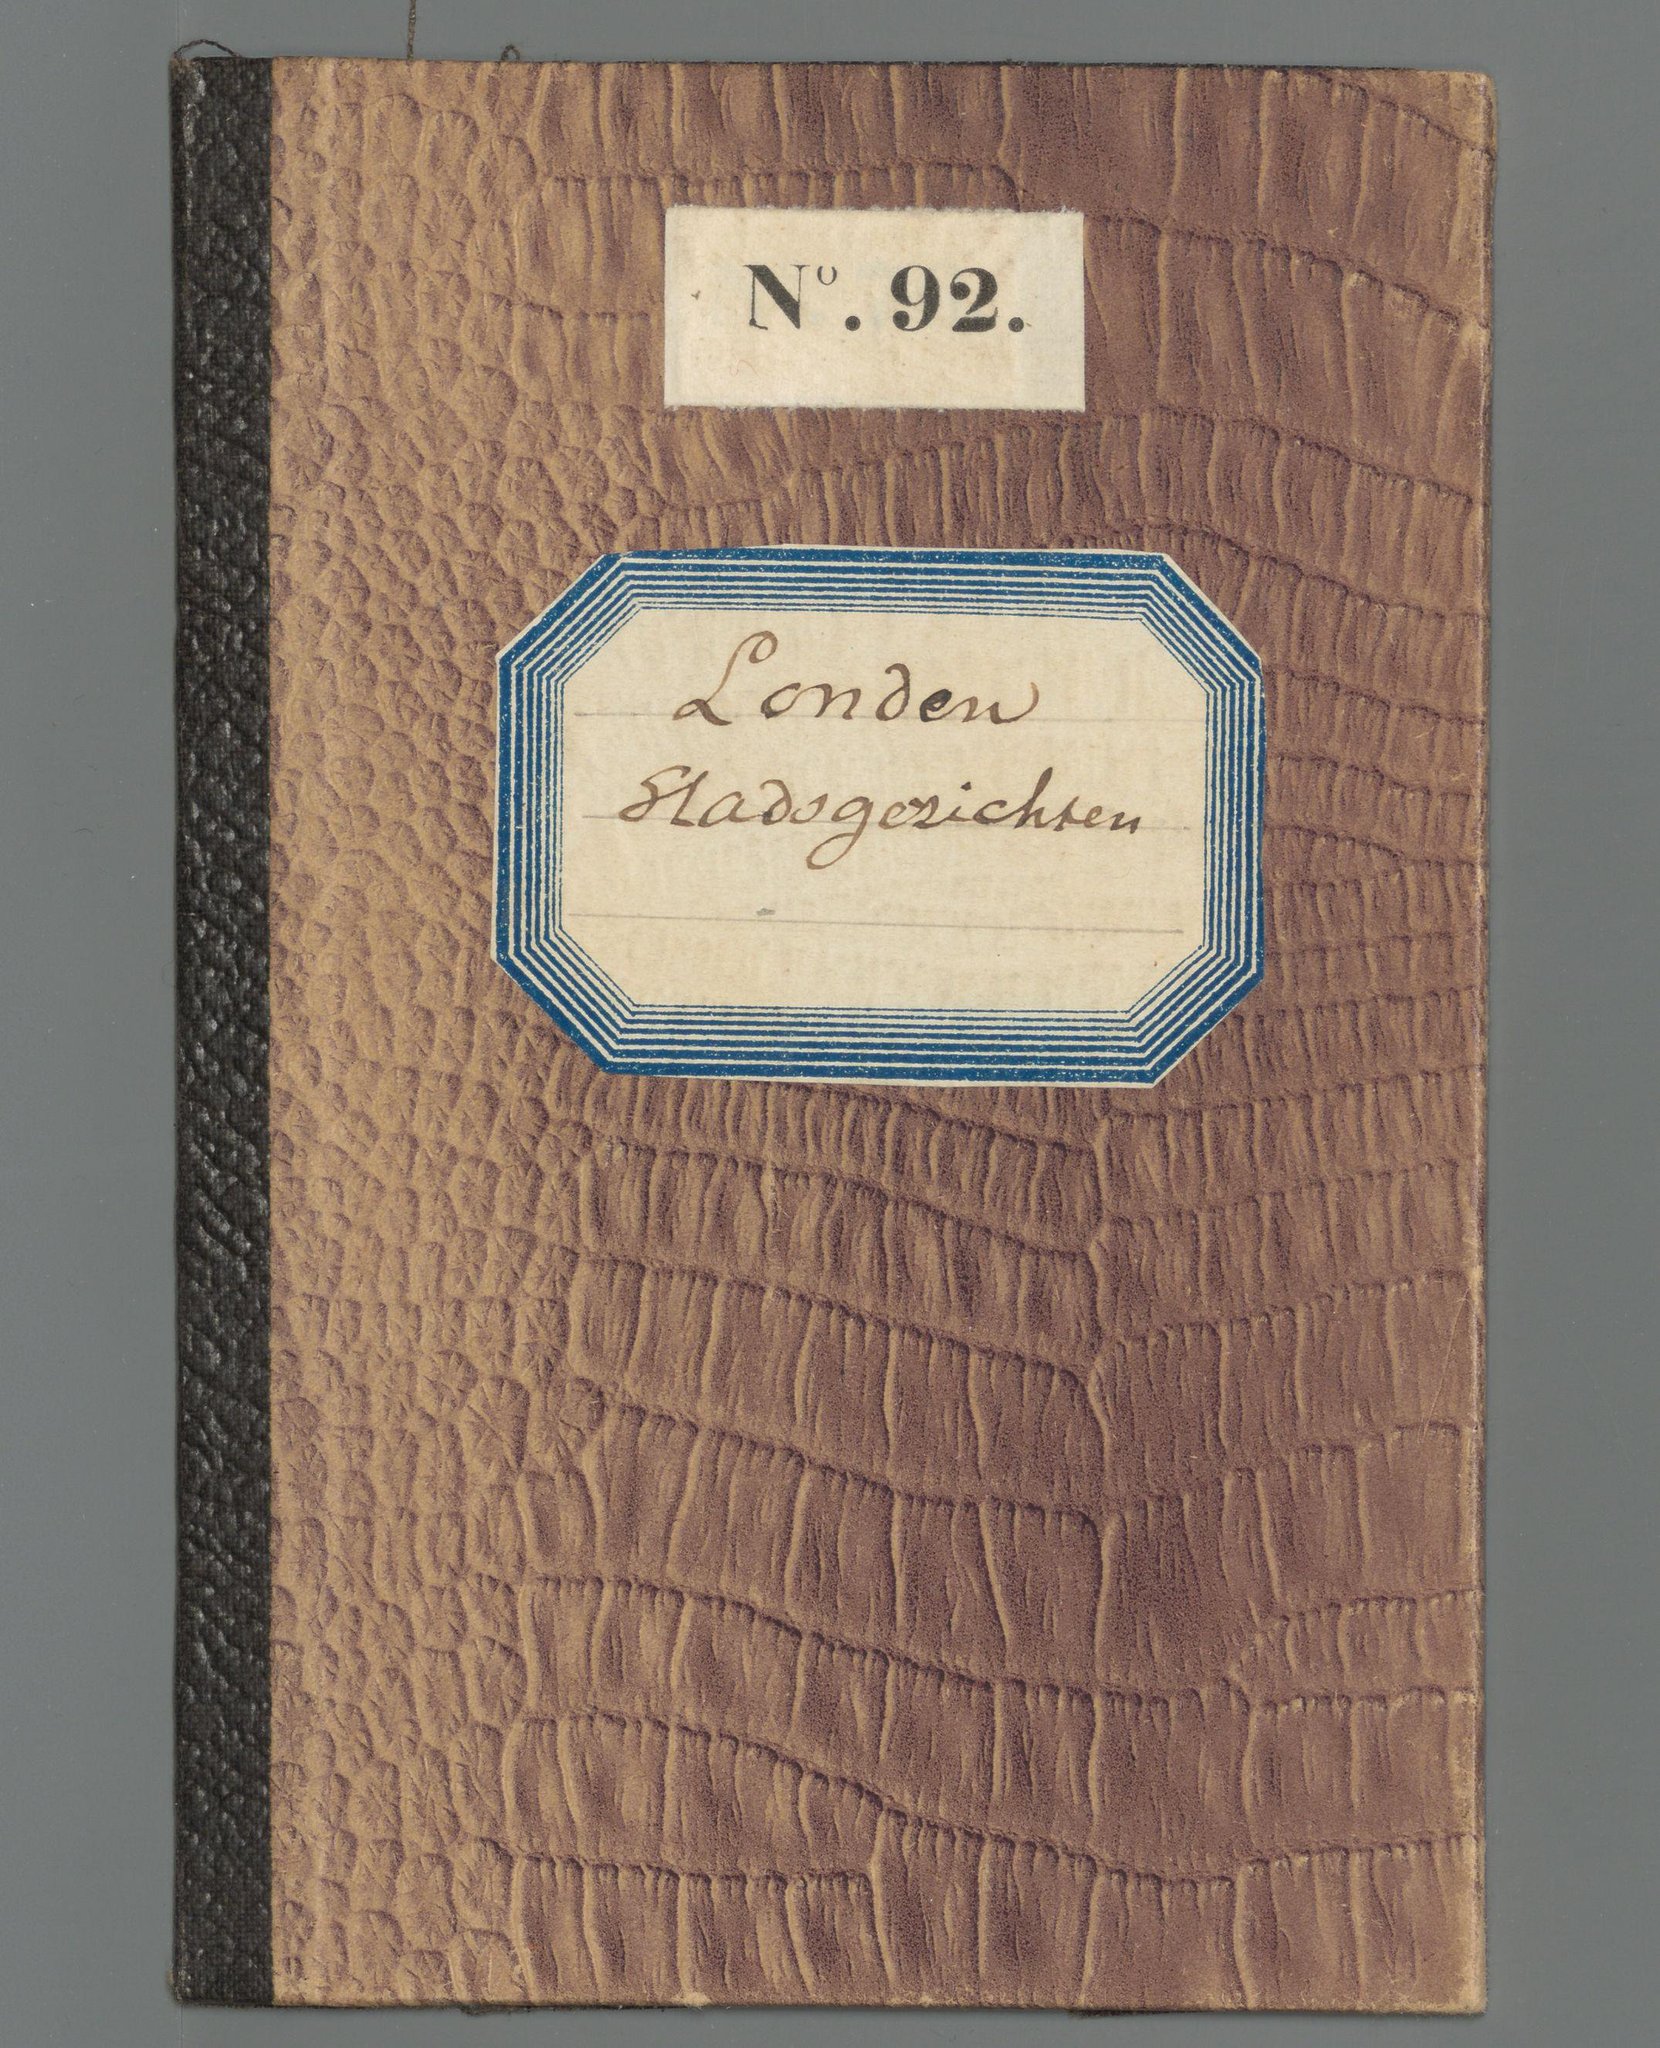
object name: wrapper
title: Omslag voor 68 prentbriefkaarten met stadsgezichten uit Londen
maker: Anonymous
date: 1900-1950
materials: cardboard, paper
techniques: lithograph, writing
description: In de omslag zit een kaart ingestoken met daarop een korte beschrijving van de inhoud.